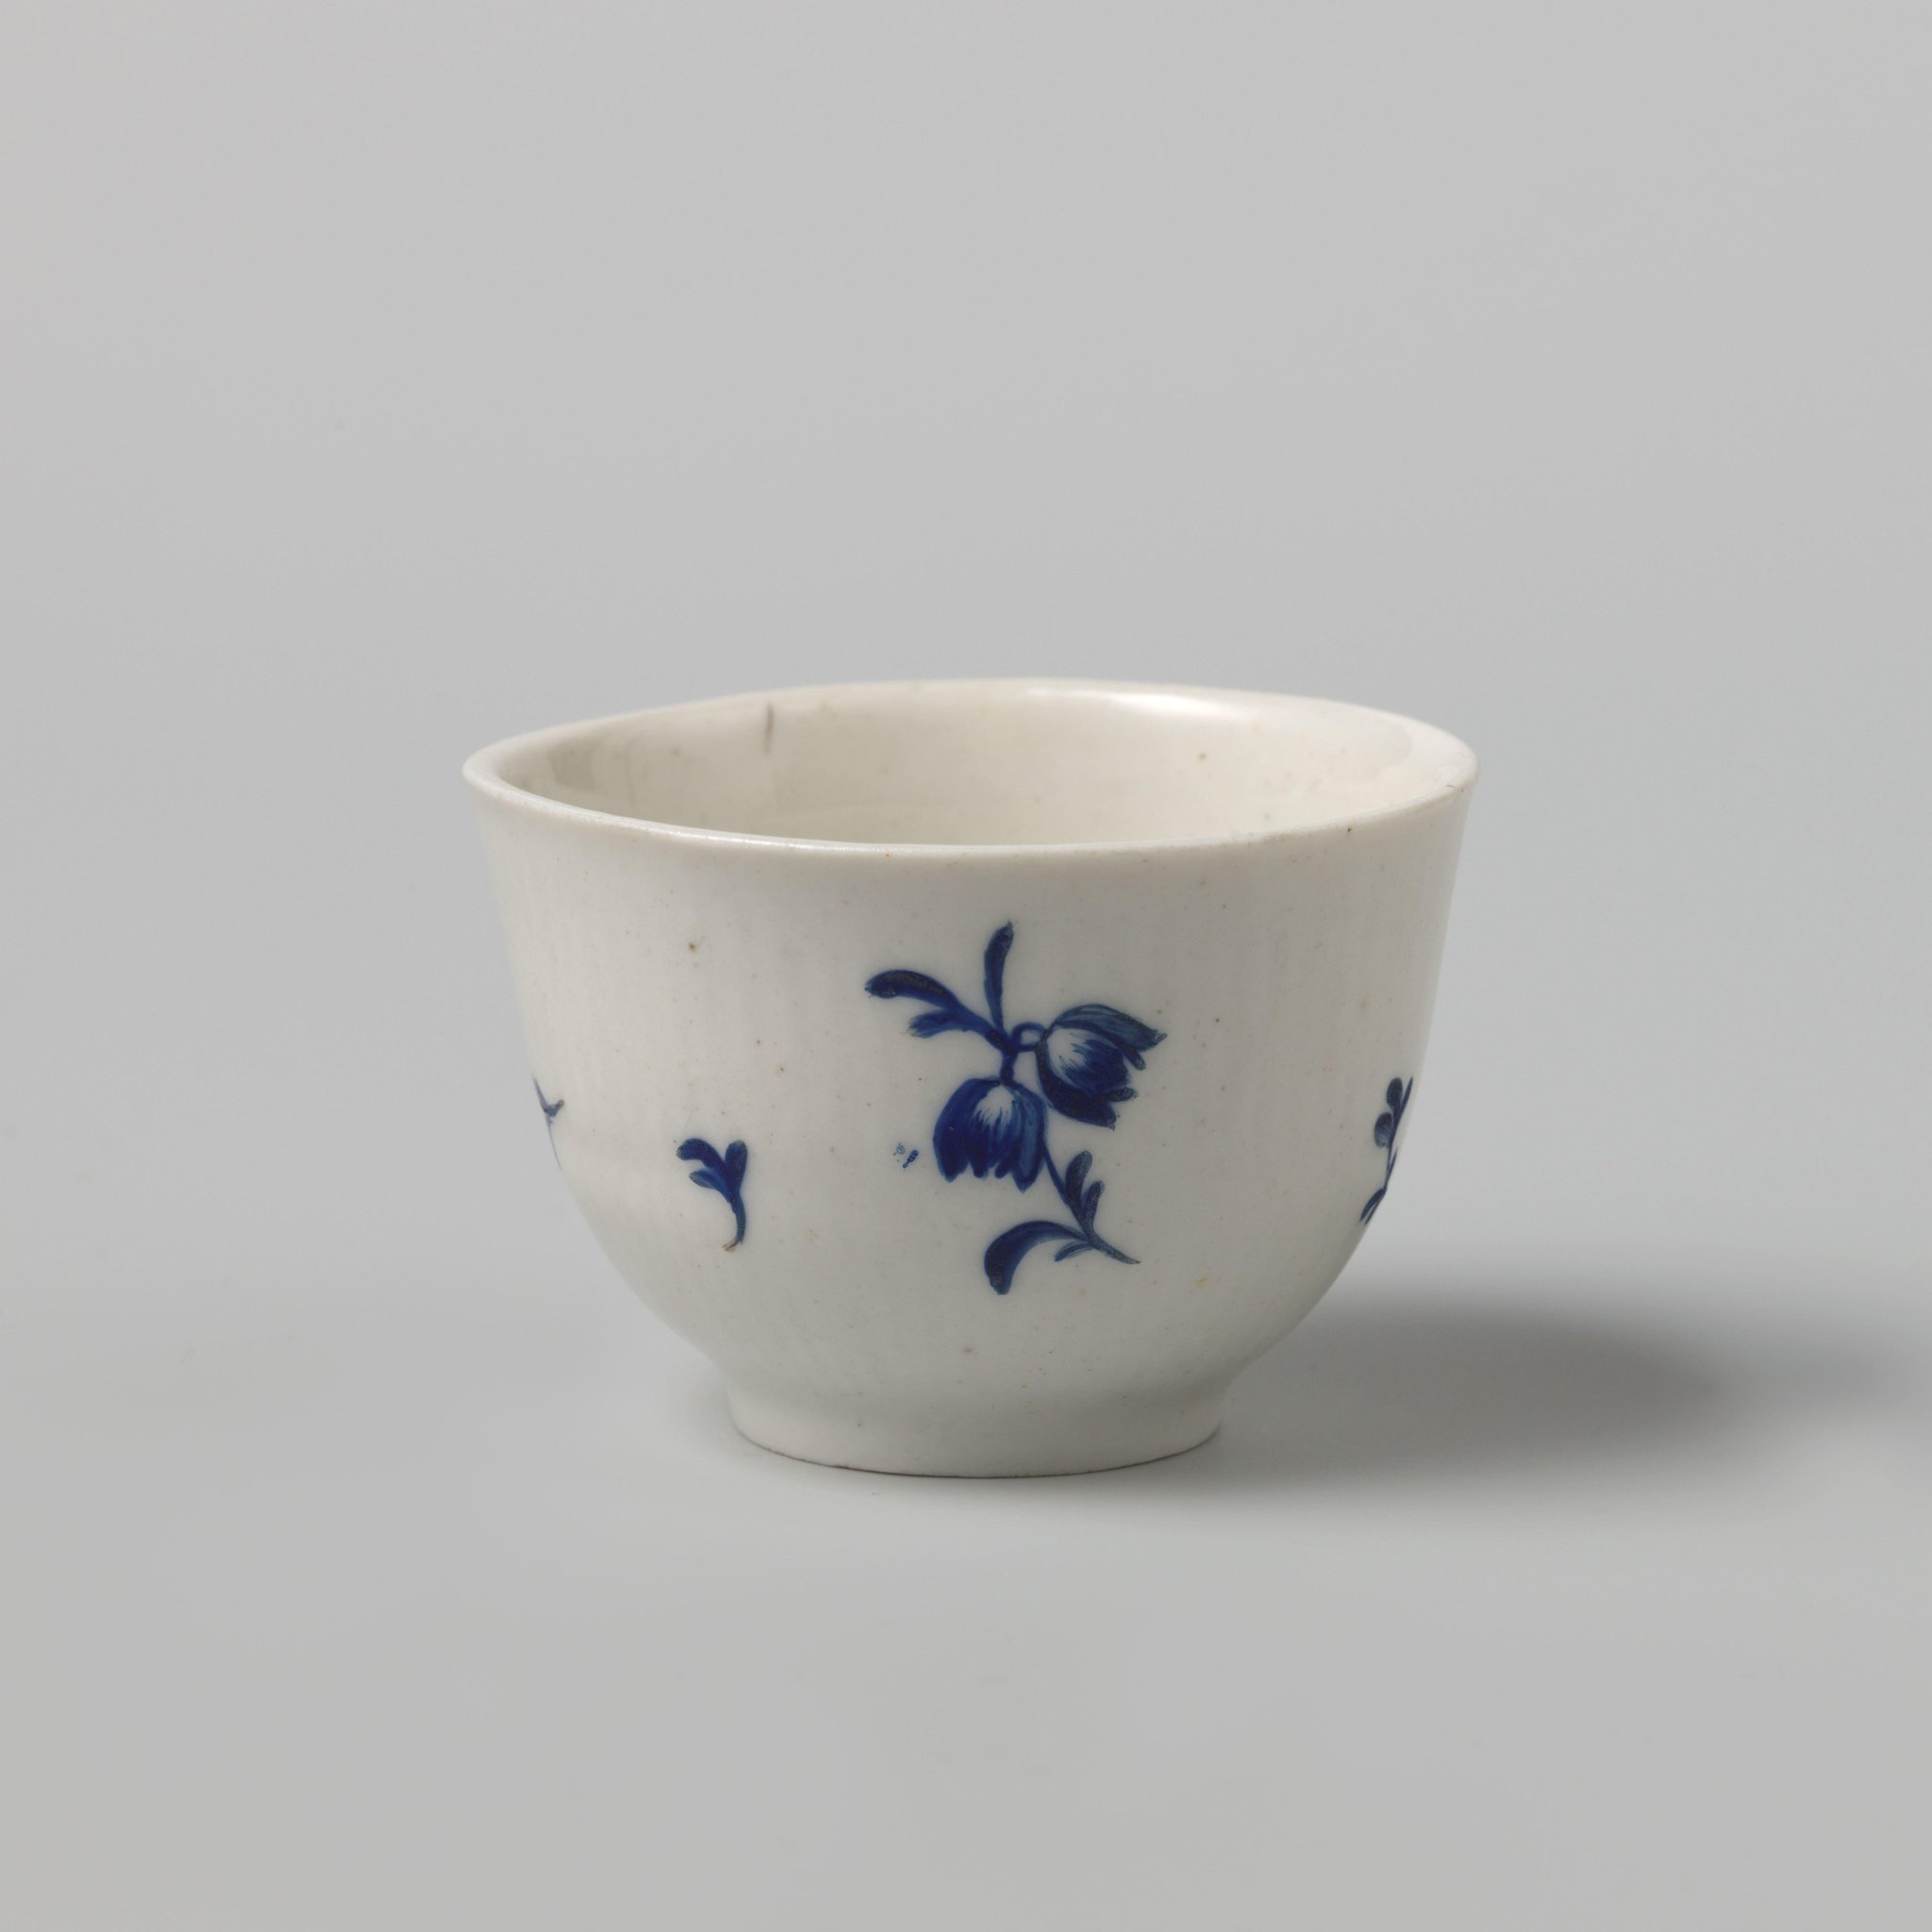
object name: cup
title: Kop, beschilderd met strooibloemen en bladeren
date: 1780-1784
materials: porcelain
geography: loosdrecht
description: Tea cup and saucer. Porcelain, decorated in underglaze blue. Loosdrecht, c. 1780 - 1784. Factory under direction of Friedrich Daeuber. Anonymous loan.